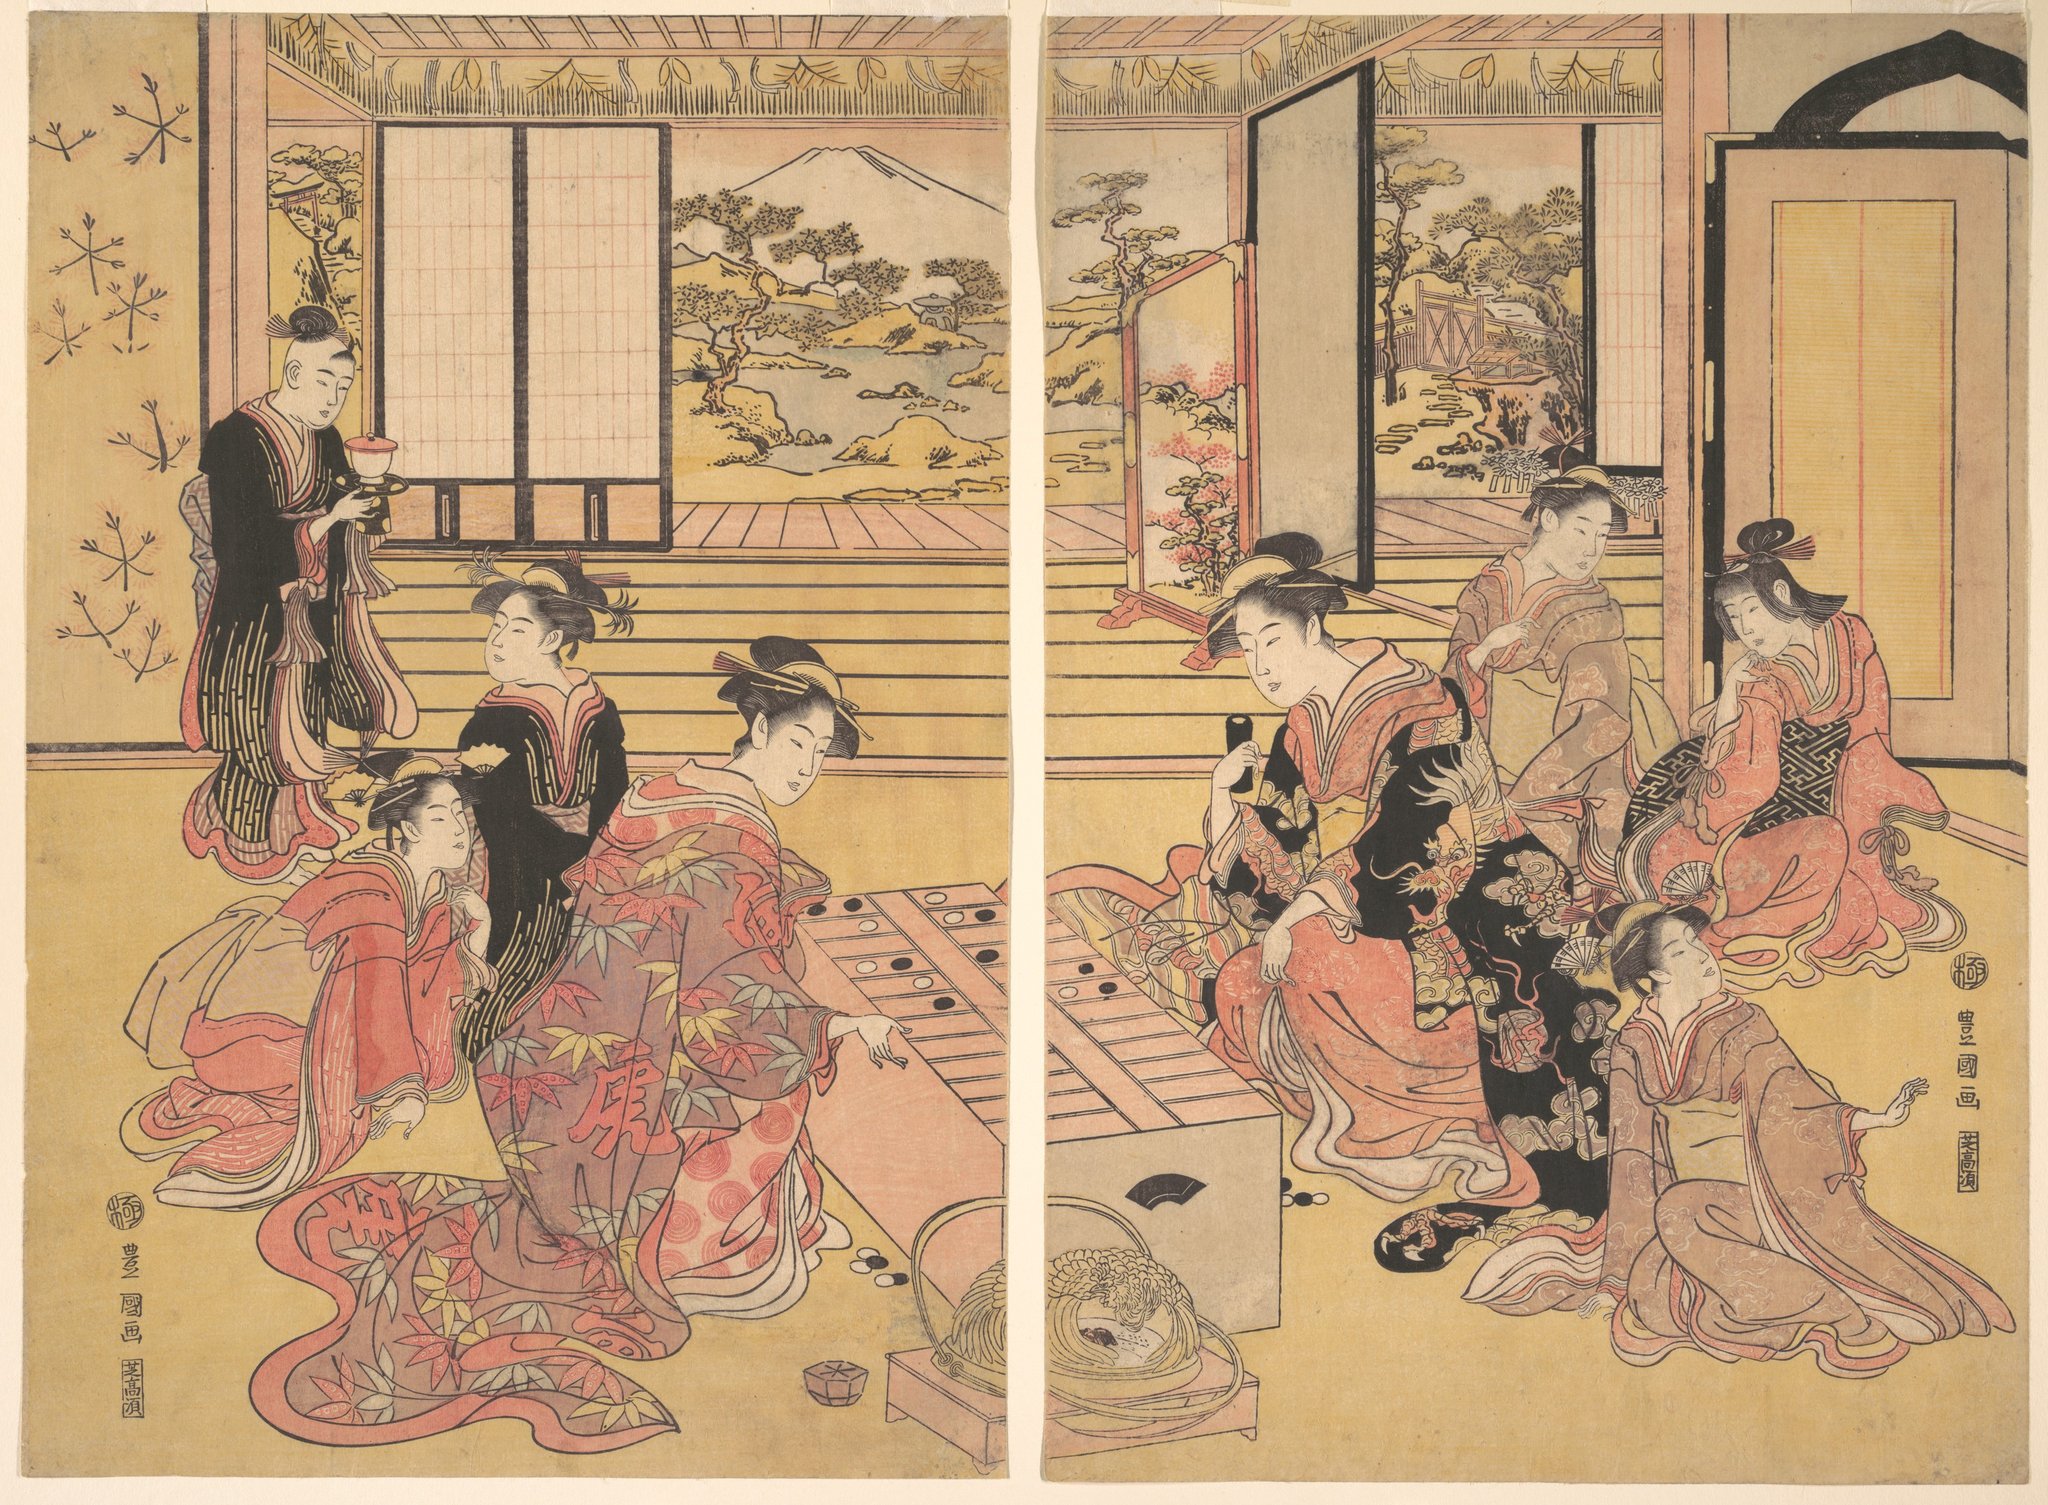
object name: print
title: Two Young Women Playing a Game of Sugoroku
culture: japanese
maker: utagawa toyokuni i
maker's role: artist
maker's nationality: japanese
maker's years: 1769-1825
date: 1769-1825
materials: ink, paper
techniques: woodblock print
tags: women,games